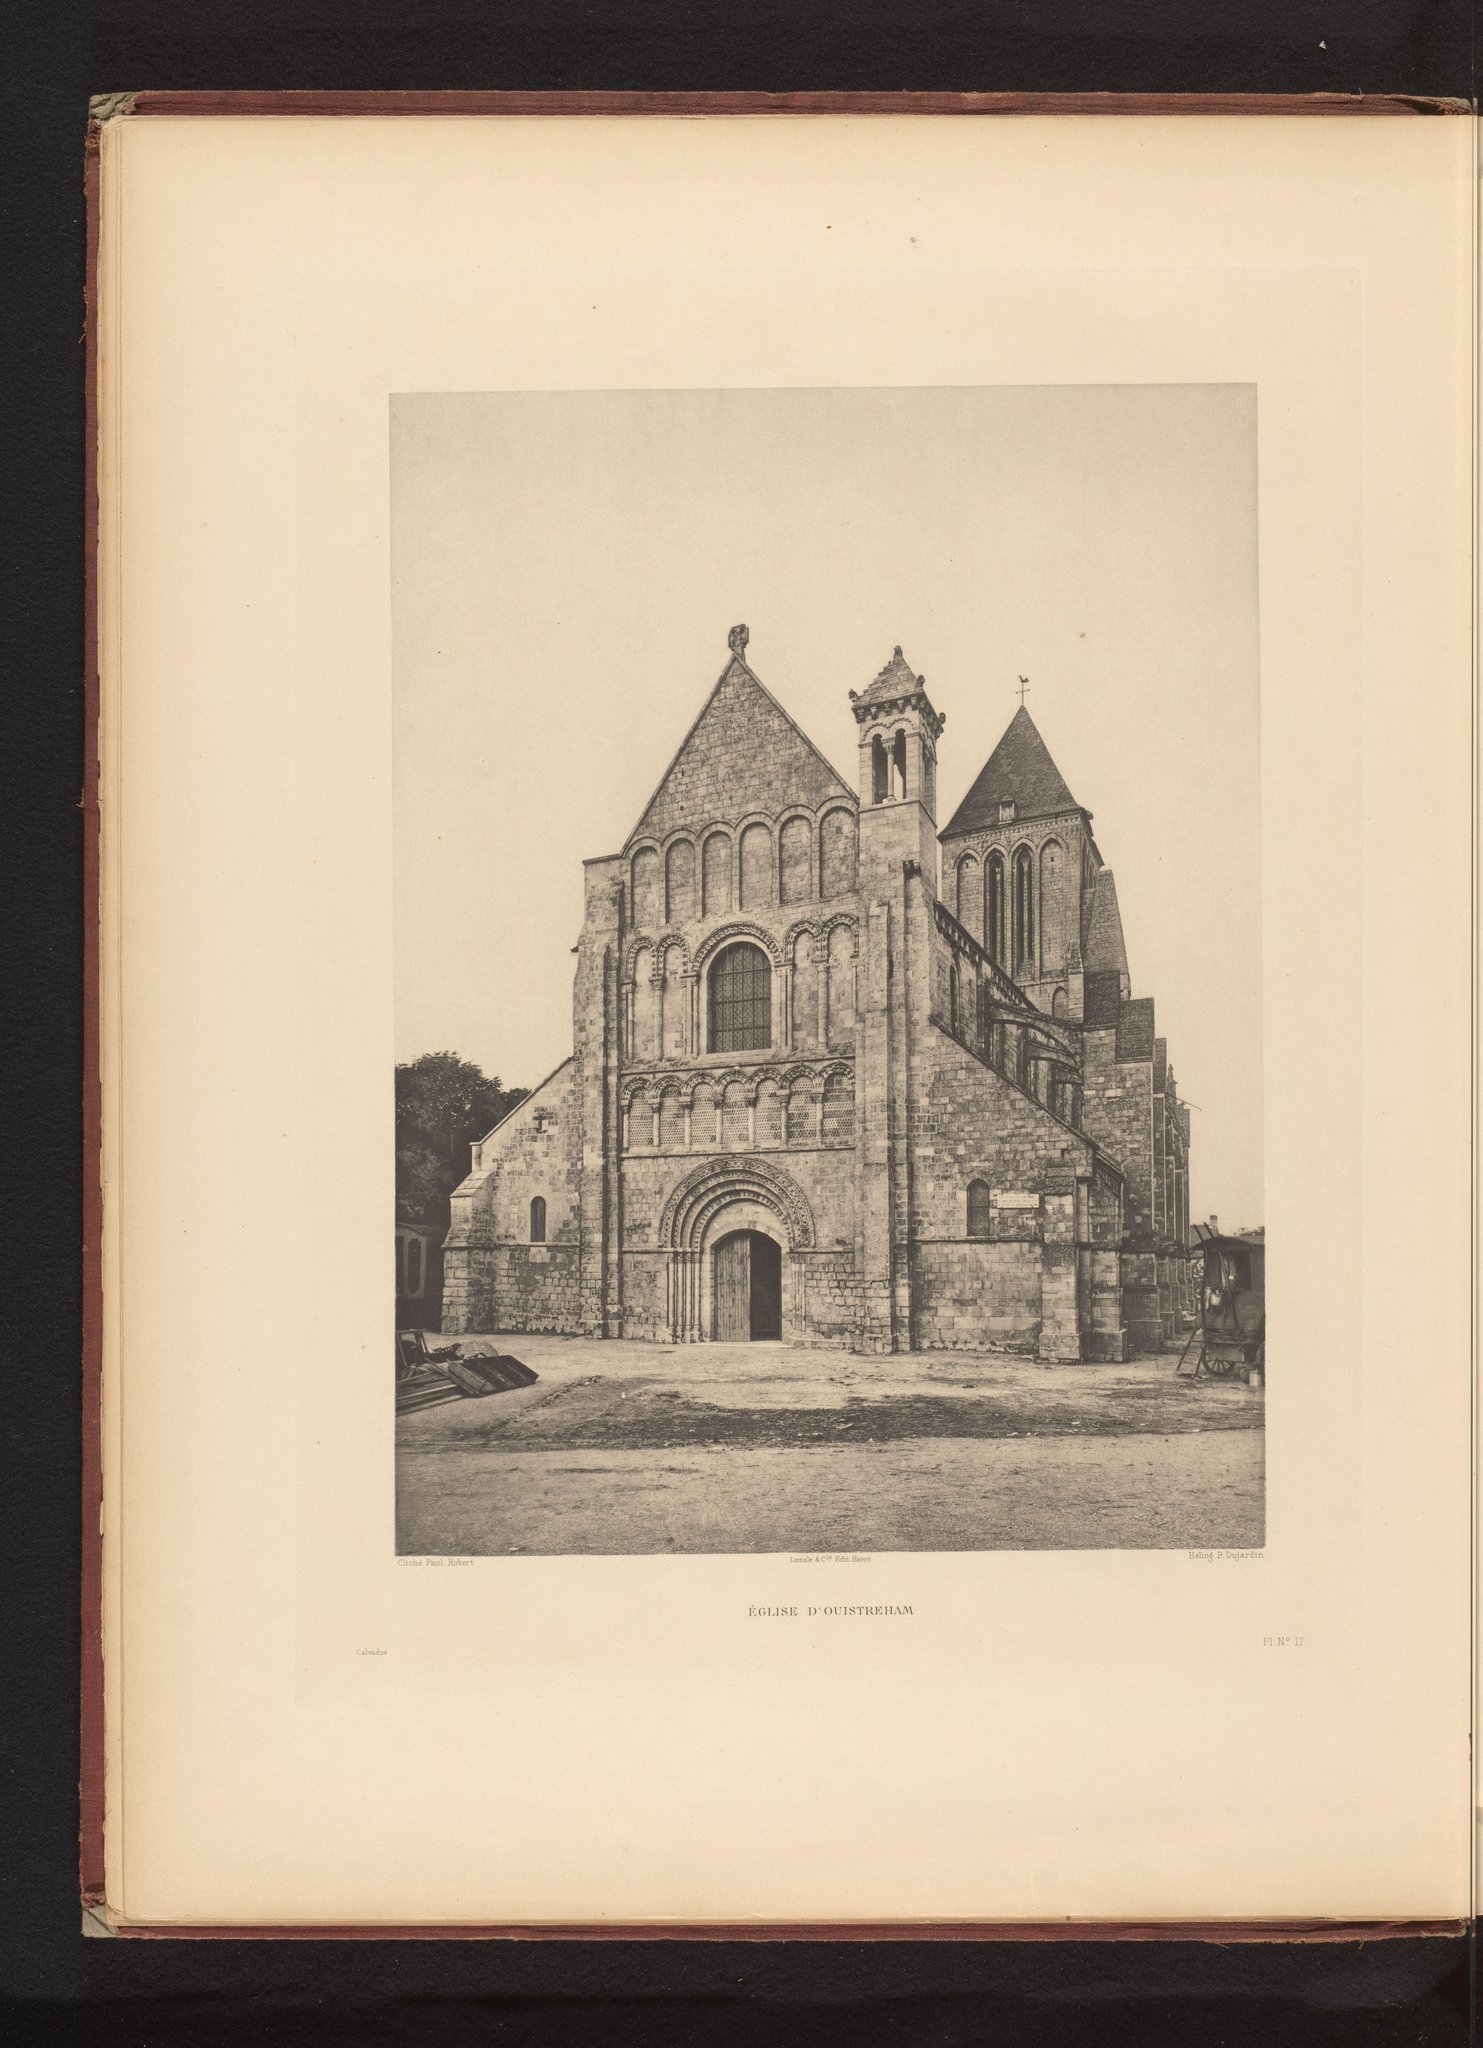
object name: photomechanical print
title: Église d'Ouistreham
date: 1890-1895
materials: paper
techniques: photoaquatint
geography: le havre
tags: church (exterior)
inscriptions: inscription: ‘Calvados.’, number: ‘Pl. No. 17’